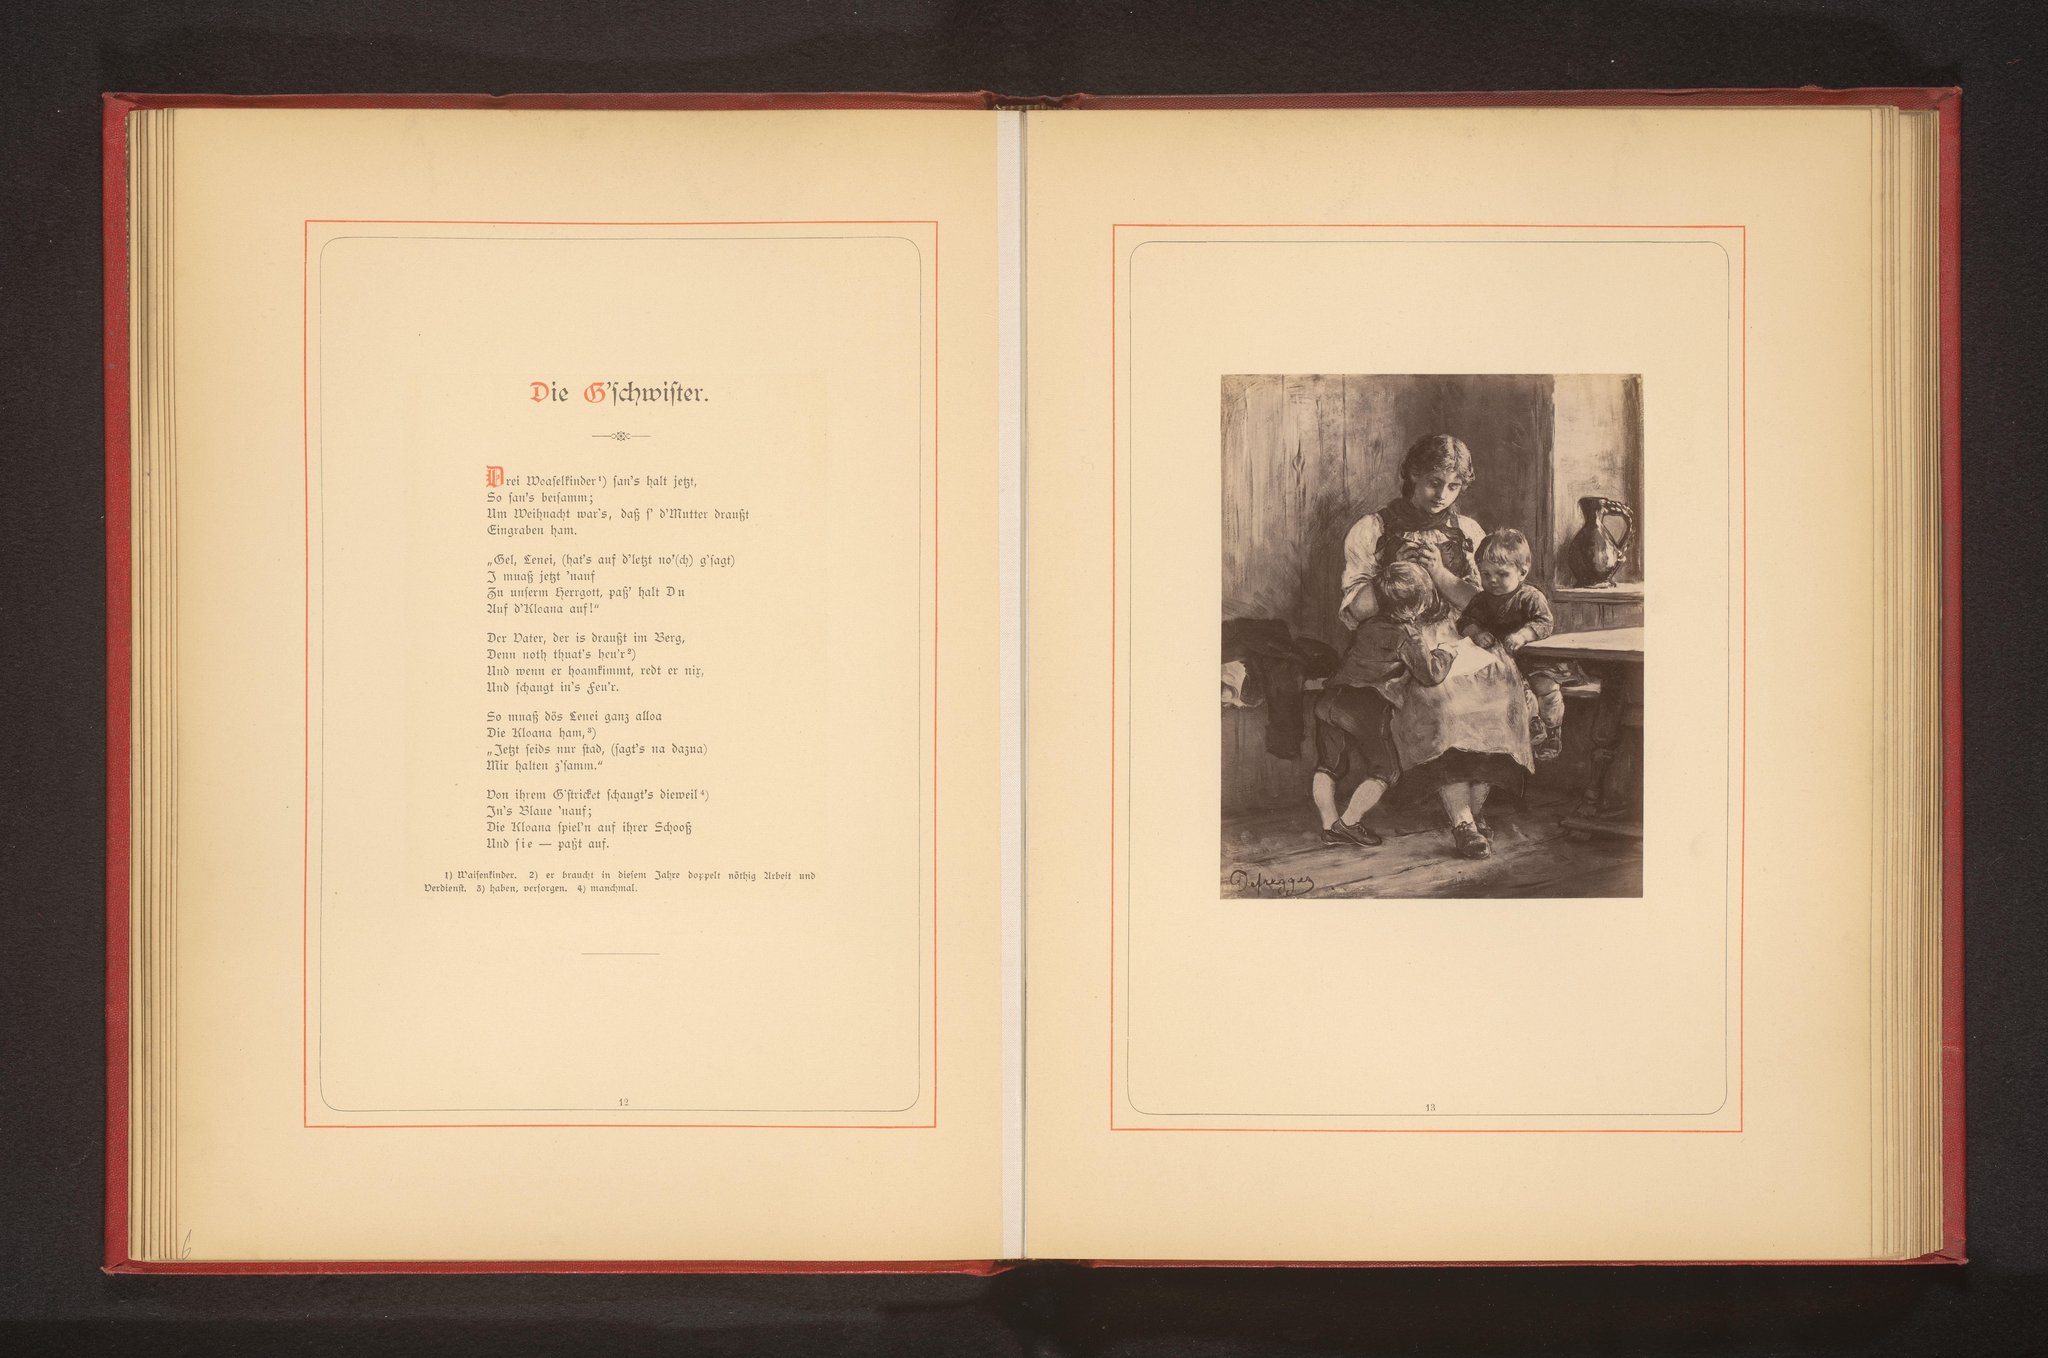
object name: photograph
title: Fotoreproductie van een schilderij, voorstellende een meisje met twee kinderen in een interieur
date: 1873-1883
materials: photographic support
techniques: albumen print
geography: germany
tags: interior ~ representation of a building, child (at home)